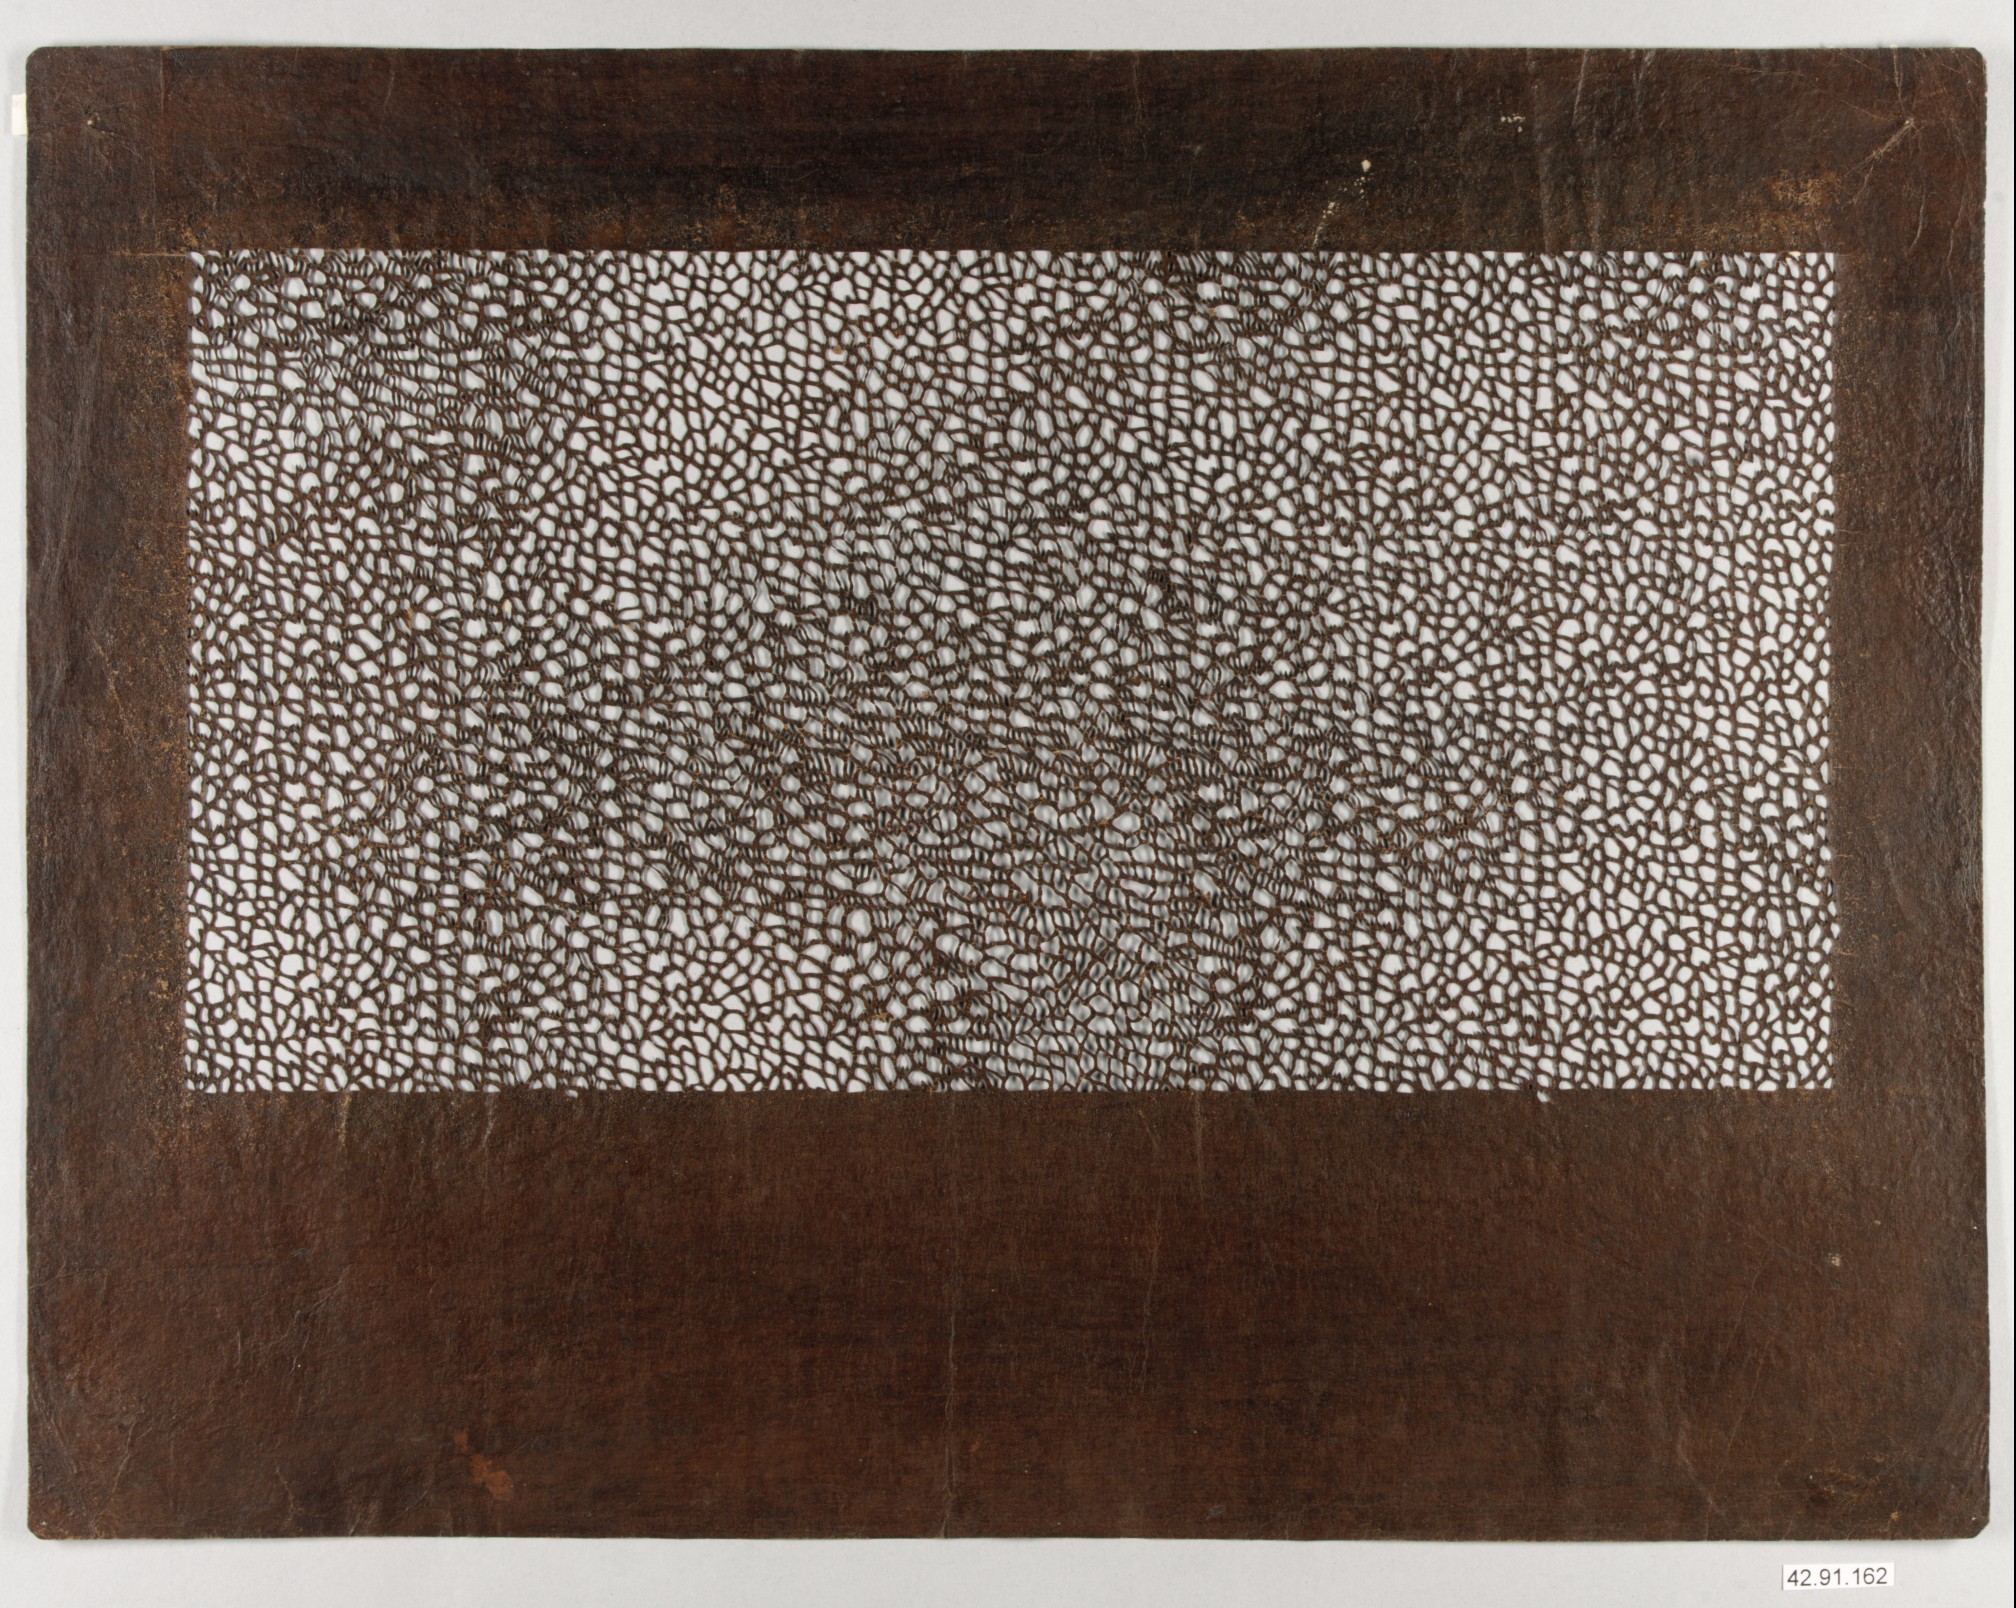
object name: stencil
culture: japanese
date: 1801-1900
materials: paper